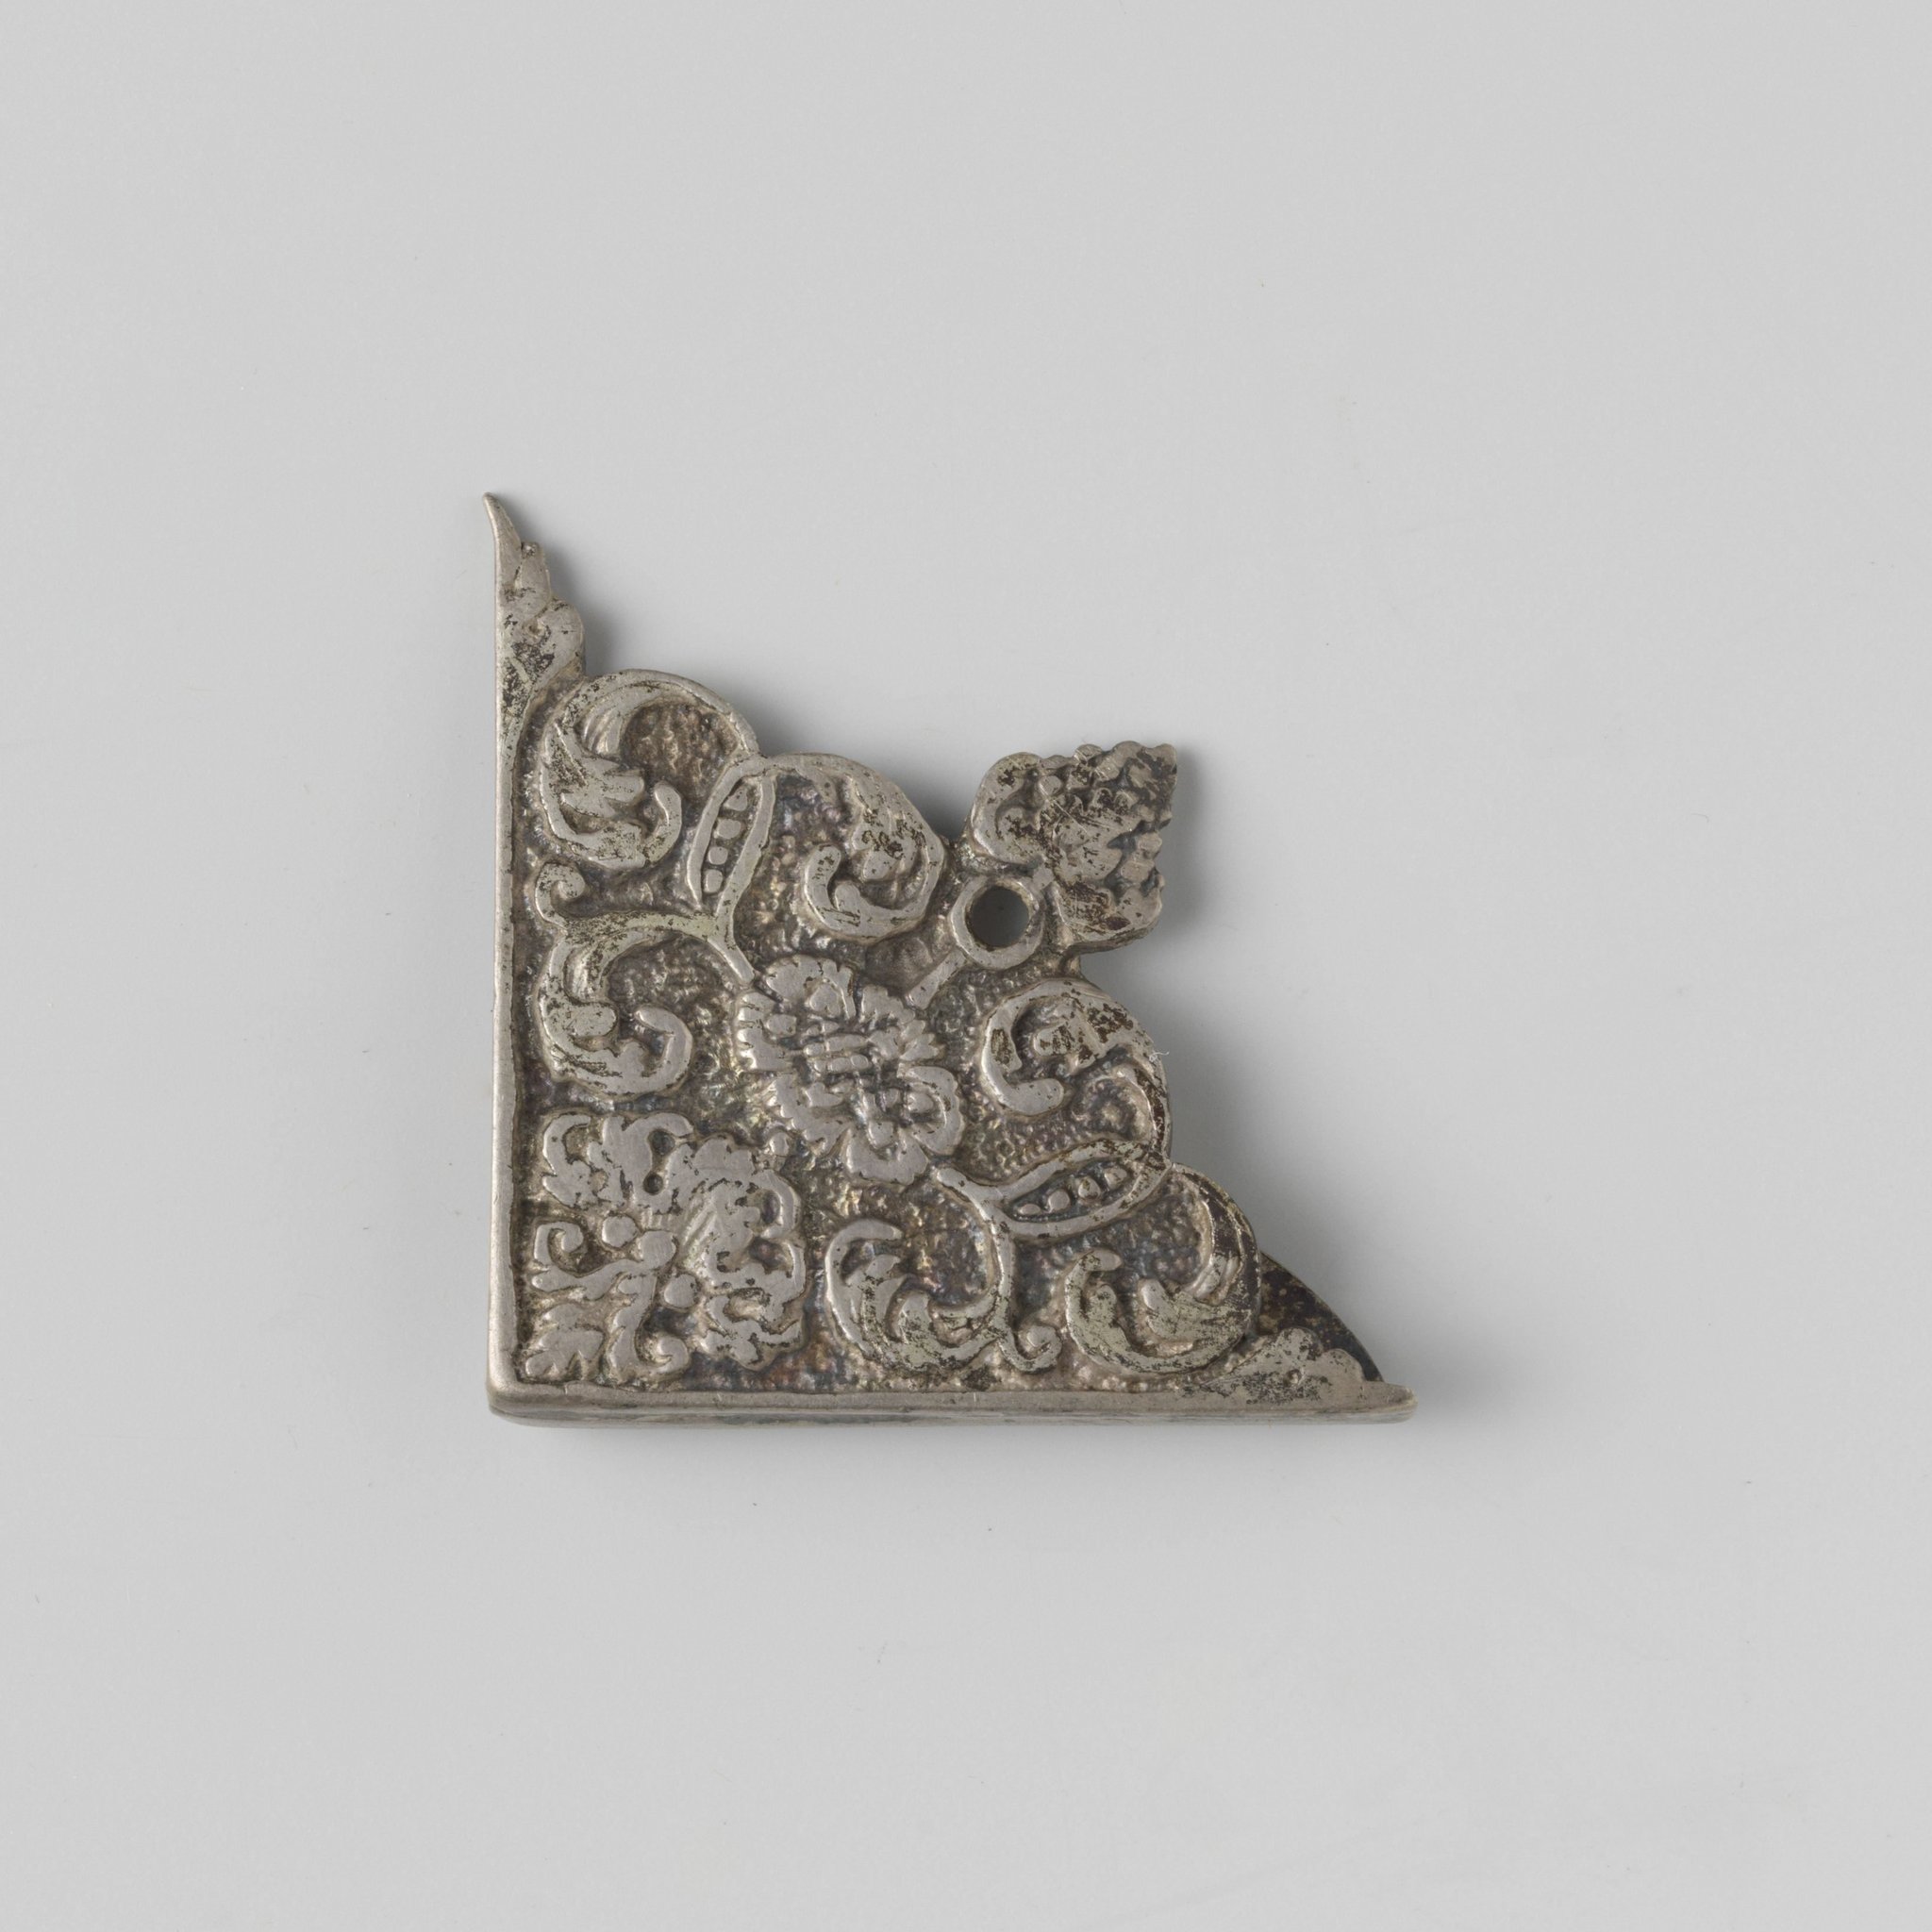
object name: binding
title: Boekband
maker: Anonymous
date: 1800-1900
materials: silver